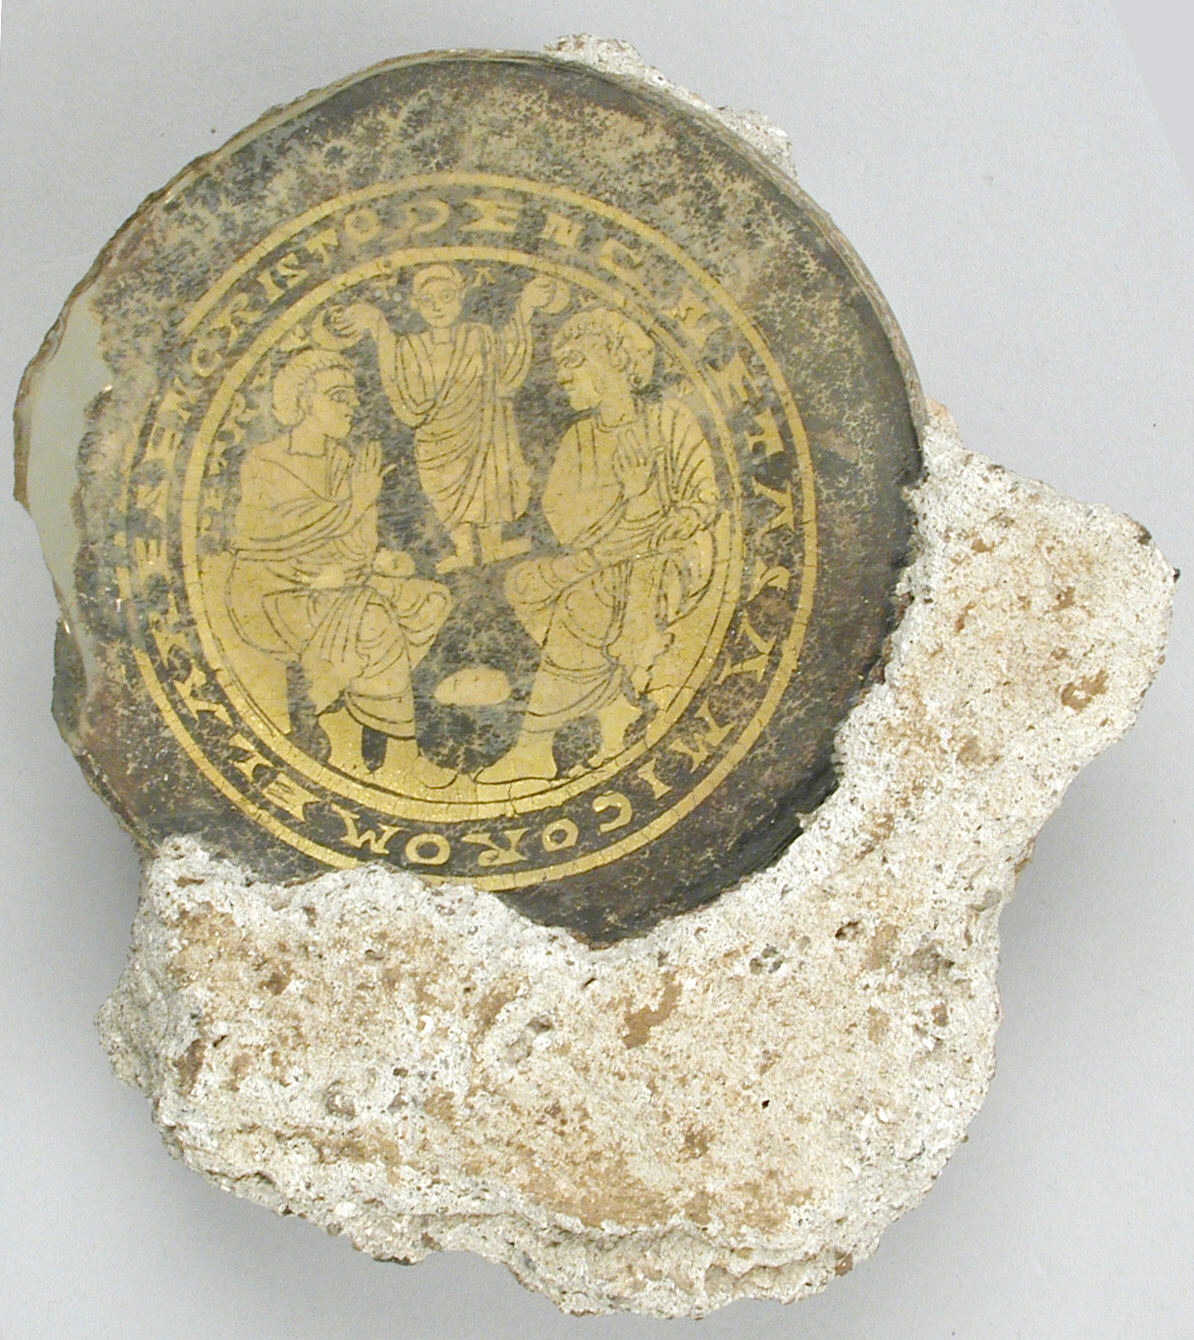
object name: bowl bottom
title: Bowl Base with Christ Giving Martyrs’ Crowns to Saints Peter and Paul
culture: byzantine or roman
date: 350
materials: glass, gold leaf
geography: probably rome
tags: christ,saint paul